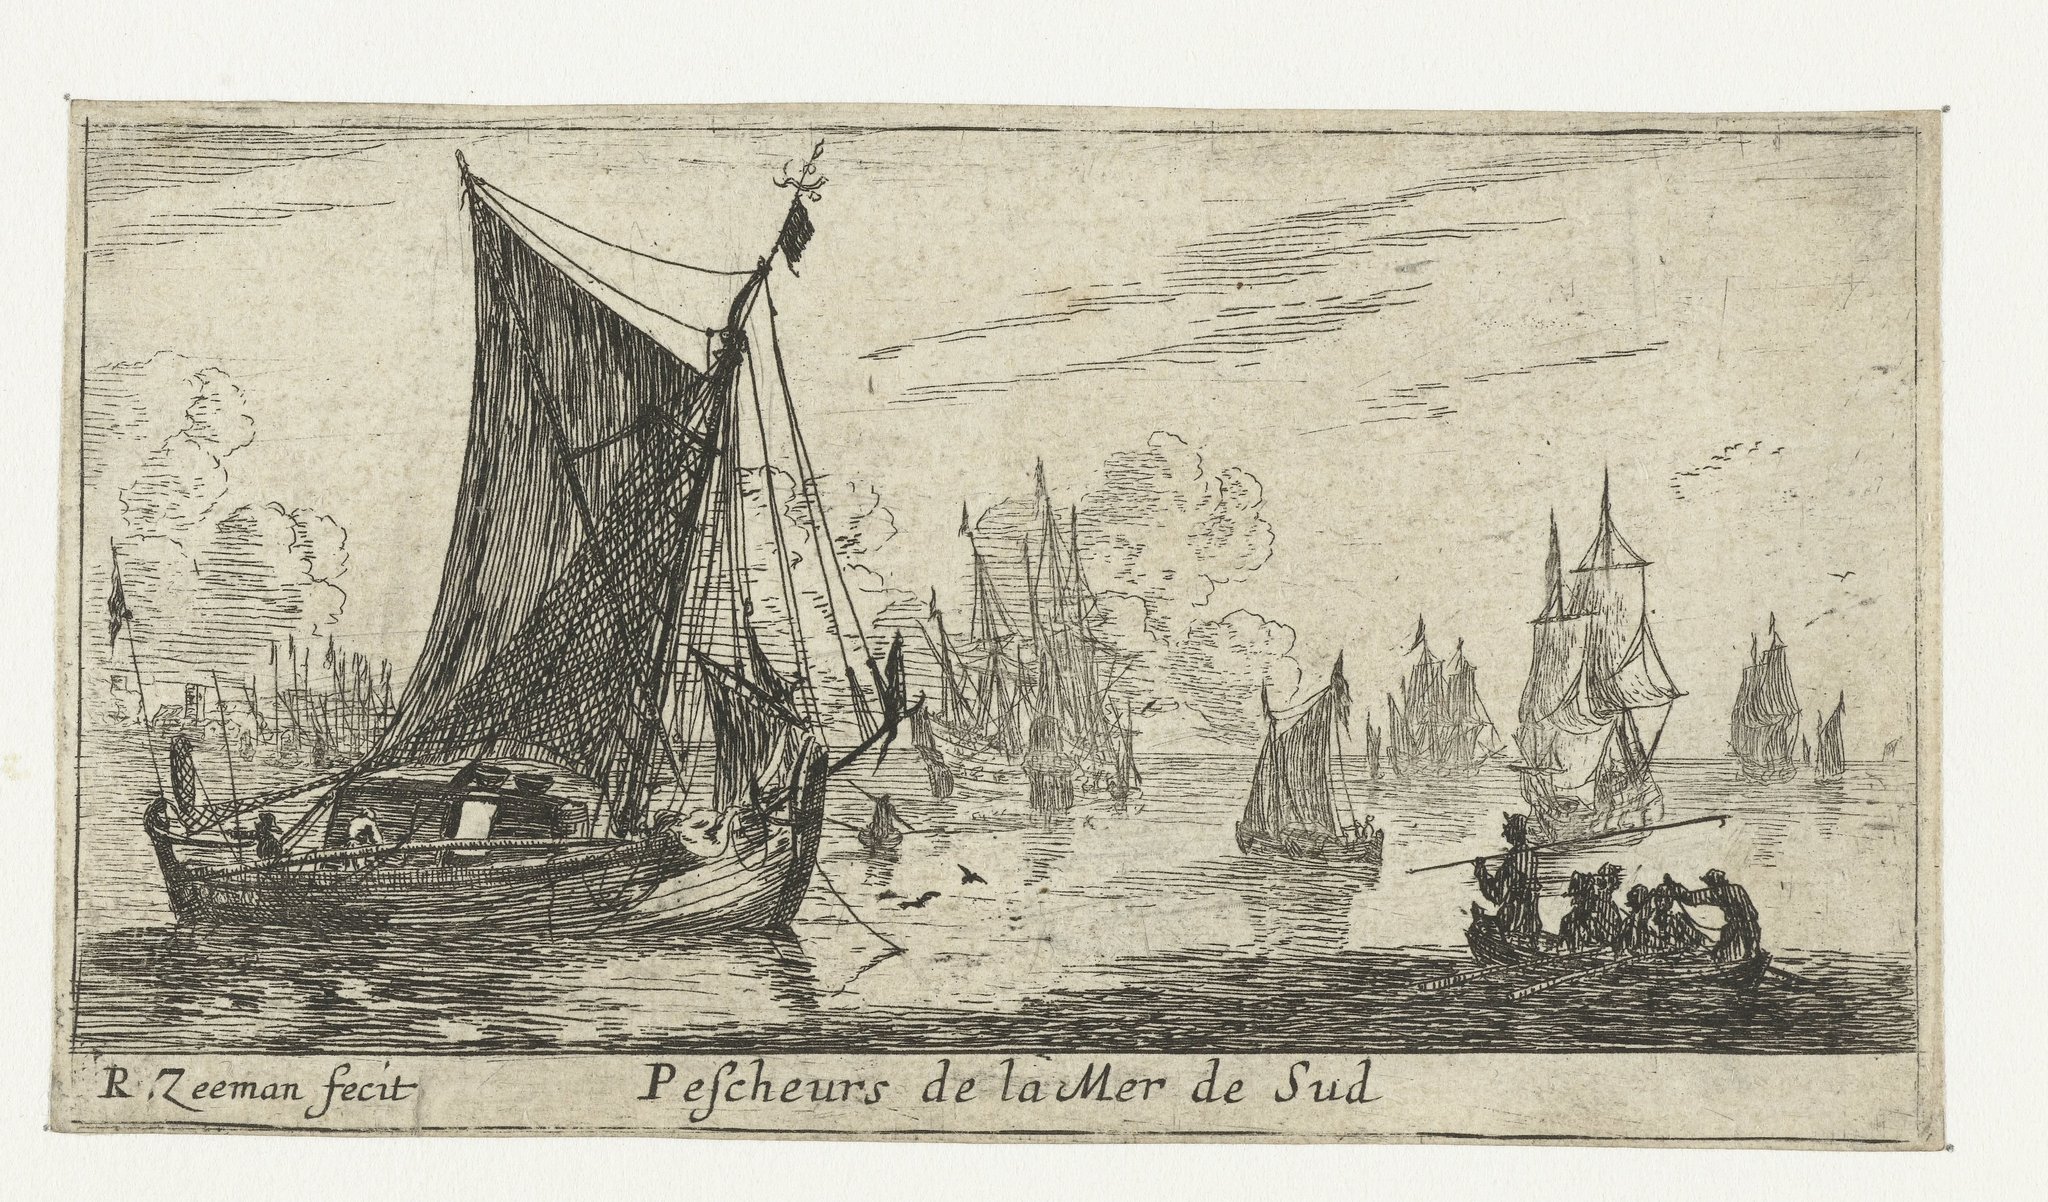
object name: print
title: Vissersboten op de Zuiderzee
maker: reinier nooms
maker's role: draughtsman, painter, print maker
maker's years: 1623-1664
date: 1650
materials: paper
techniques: etching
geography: netherlands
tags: sailing-ship, sailing-boat, sea and coastal fishery, zuiderzee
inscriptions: collector's mark: Lugt 2228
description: De Zuiderzee met rechts een roeiboot, links een visserschip en daarachter de haven en een aantal zeilschepen.